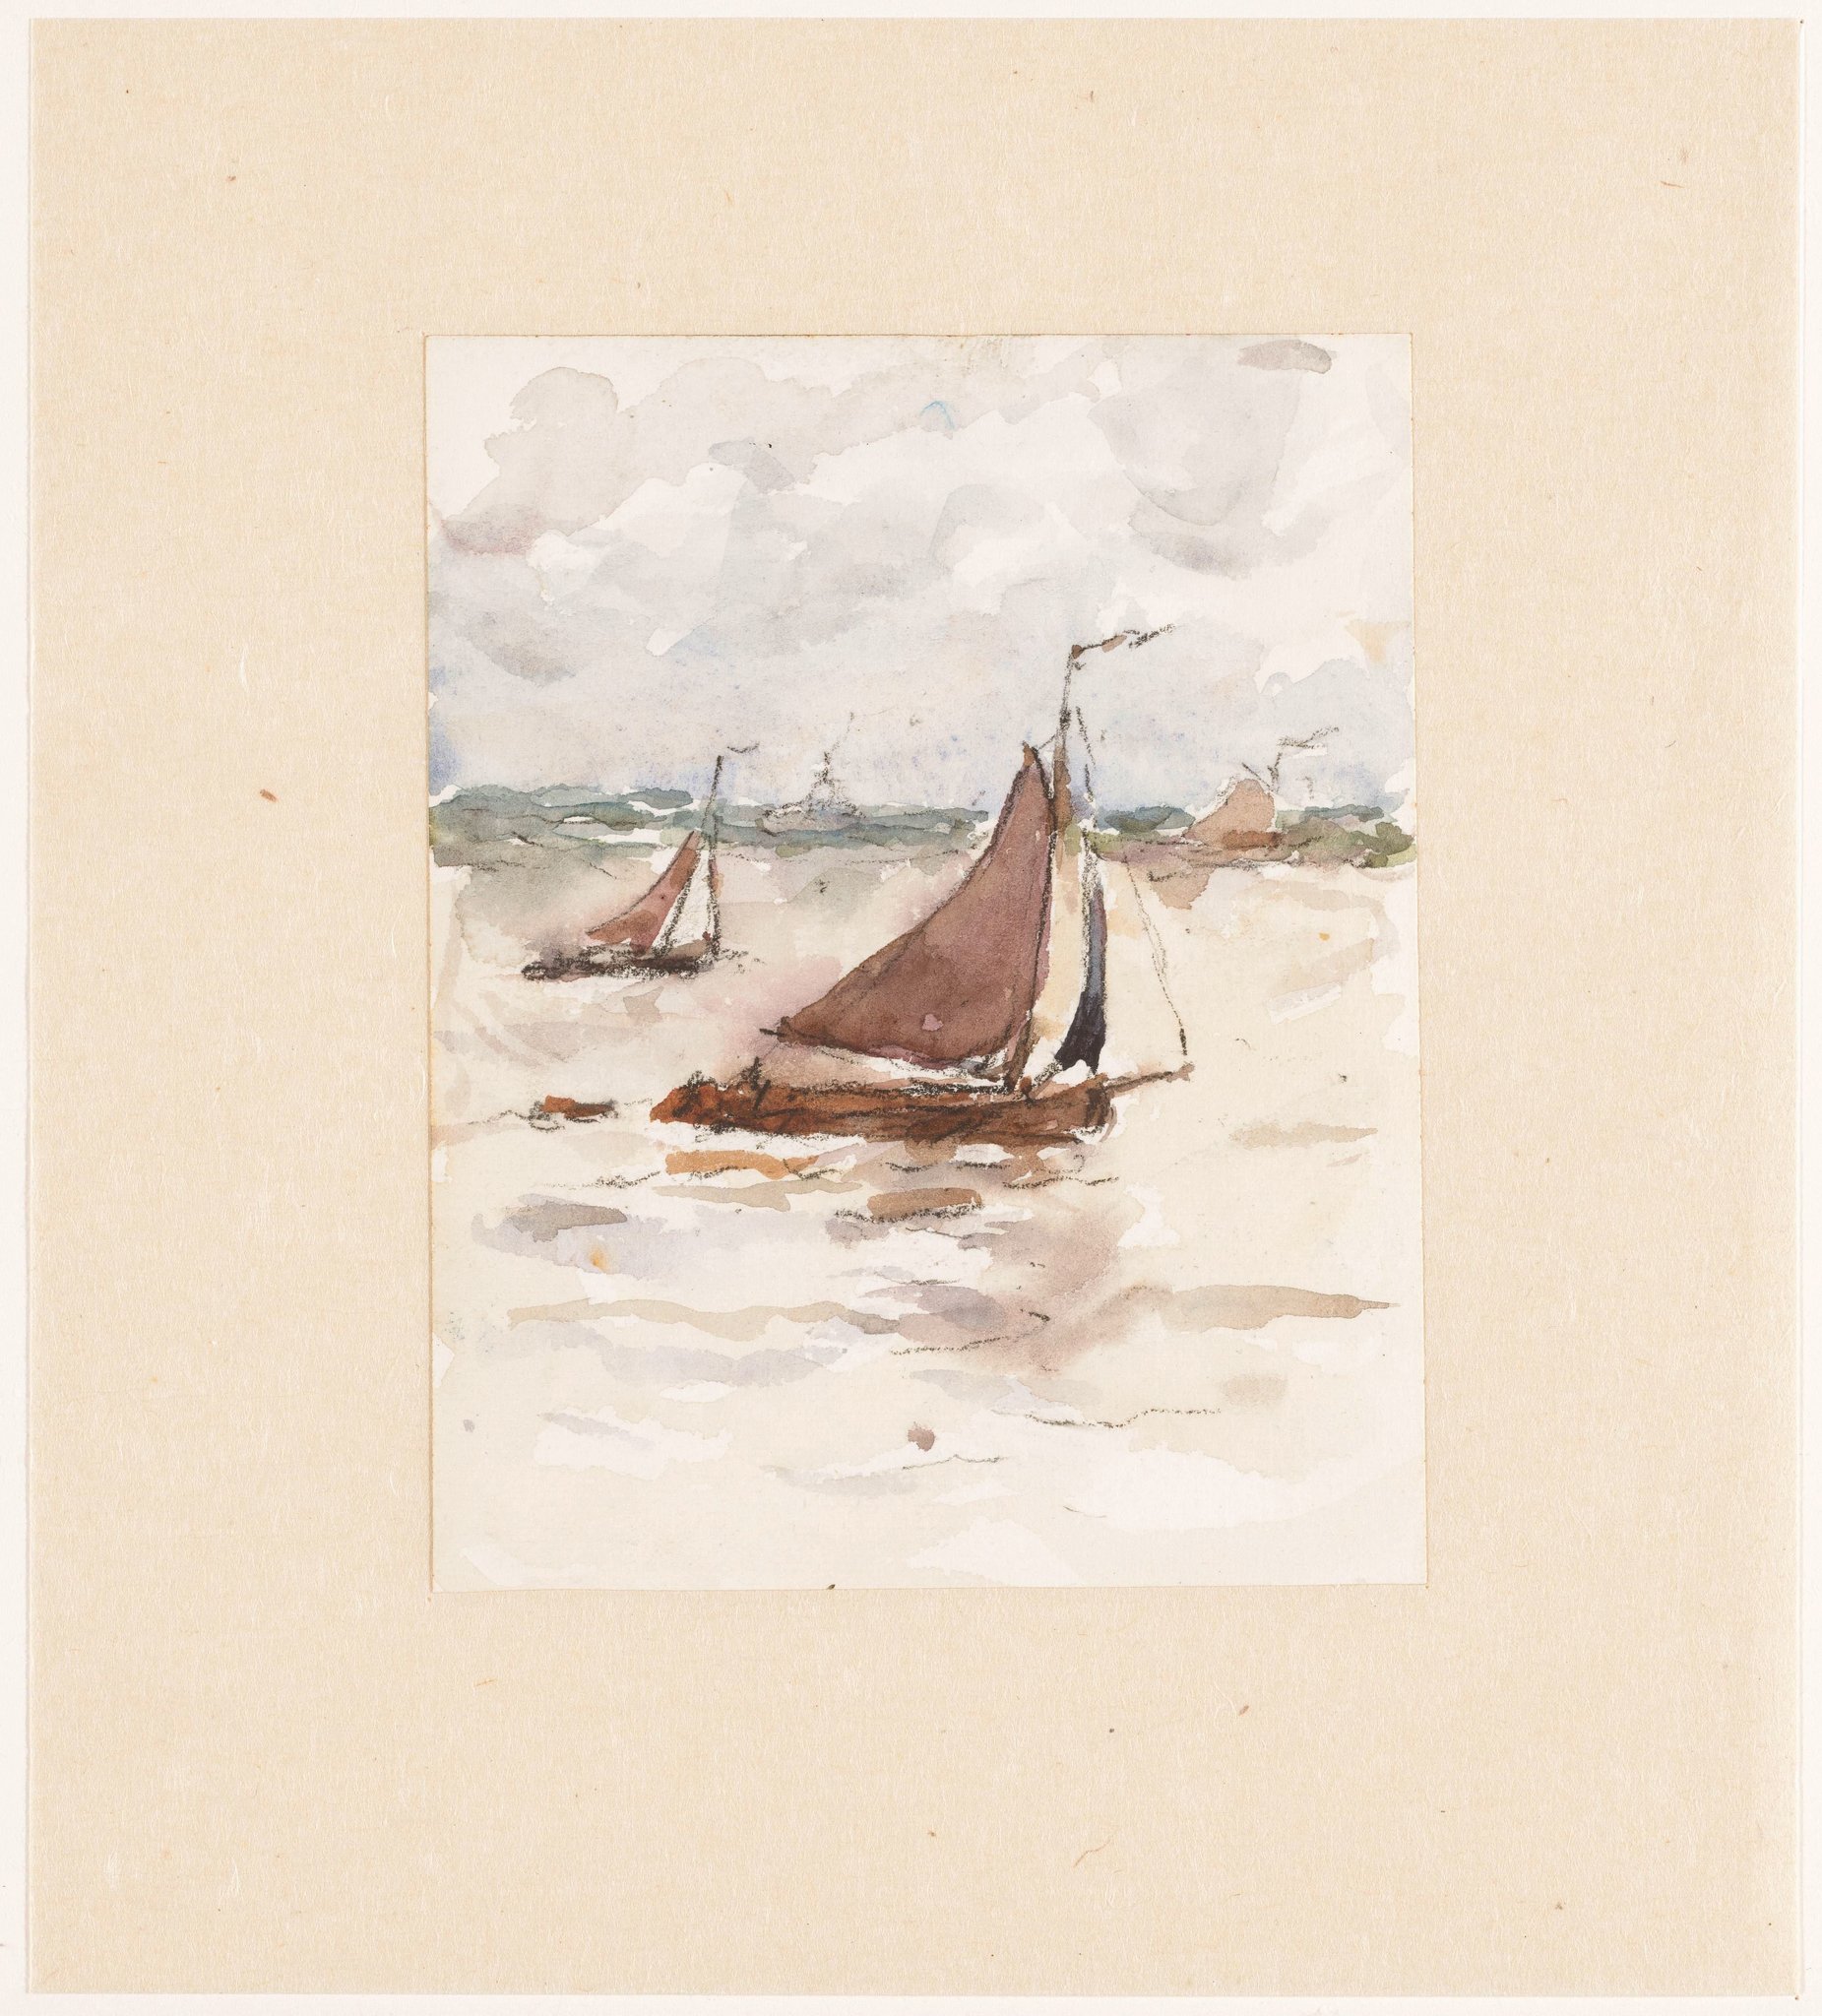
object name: drawing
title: Zeilende vissersschepen op de Schelde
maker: carel nicolaas storm van s-gravesande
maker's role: draughtsman, print maker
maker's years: 1841-1924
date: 1851-1924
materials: chalk, paper, watercolor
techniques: brush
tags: commercial fishery, ships (in general) - cc - more than one ship